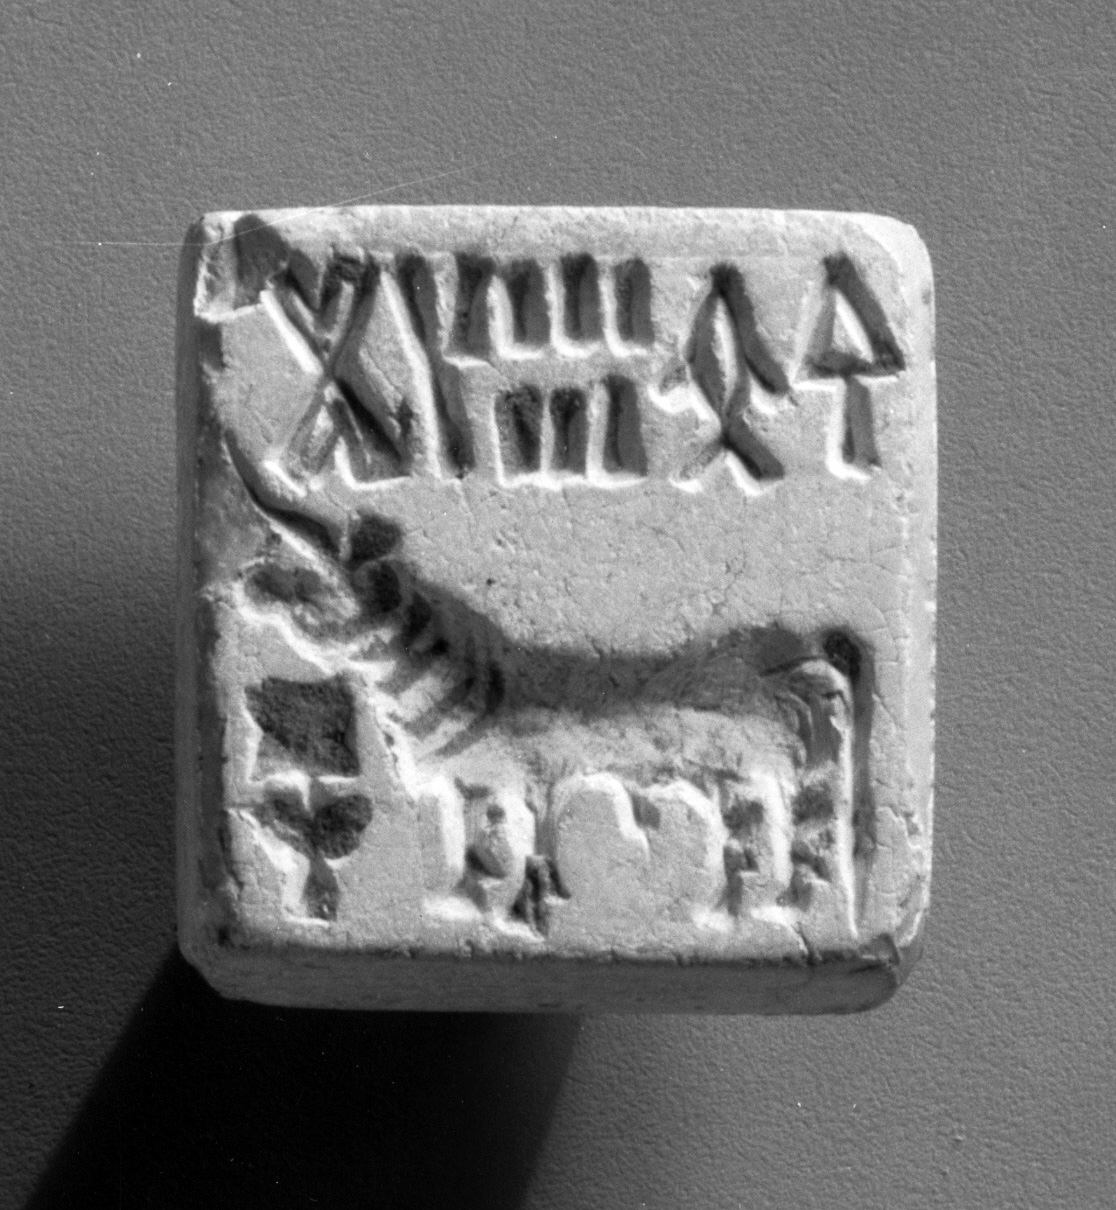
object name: seal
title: Seal with an Ox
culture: pakistani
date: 3000-1500 BCE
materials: stone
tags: indus valley,ox